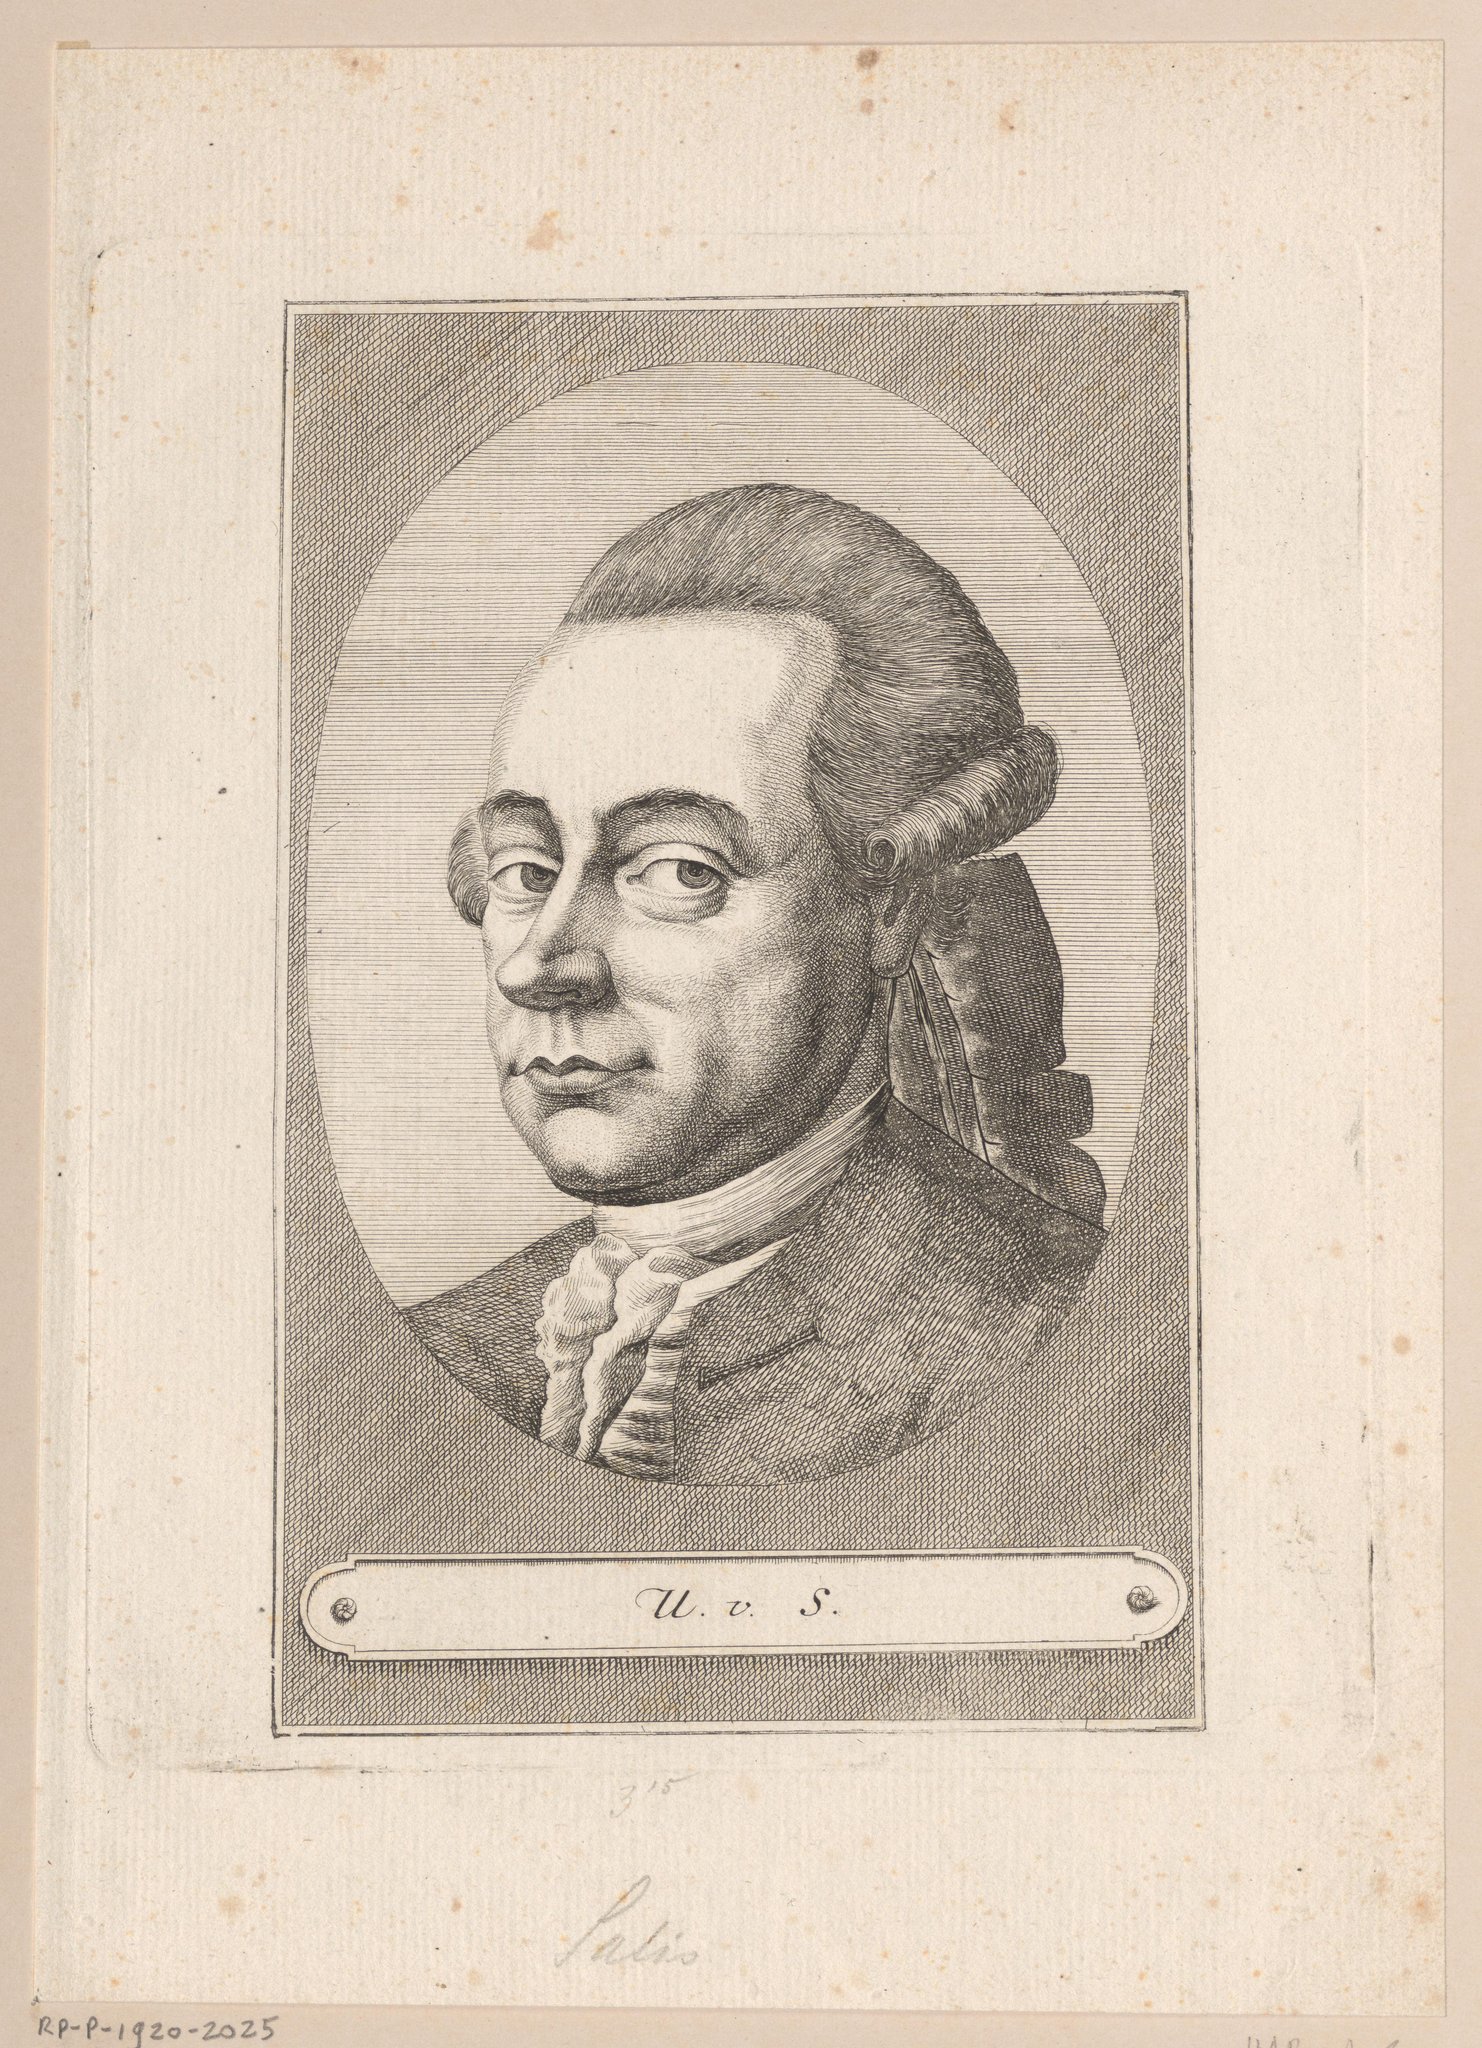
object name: print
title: Portret van Ulysses von Salis-Marschlins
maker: Anonymous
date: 1777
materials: paper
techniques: engraving, etching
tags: switzerland, vienna, politician, historical persons, politician, e.g. party leader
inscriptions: collector's mark: Lugt 2228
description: Prent waarschijnlijk uit: Lavater, Johann Caspar. Physiognomische Fragmente zur Beförderung der Menschenkenntnis und Menschenliebe. Leipzig: erven Weismanns en Reich, Winterthur: S.A. Steiner & Co., 1777, dl. 3.